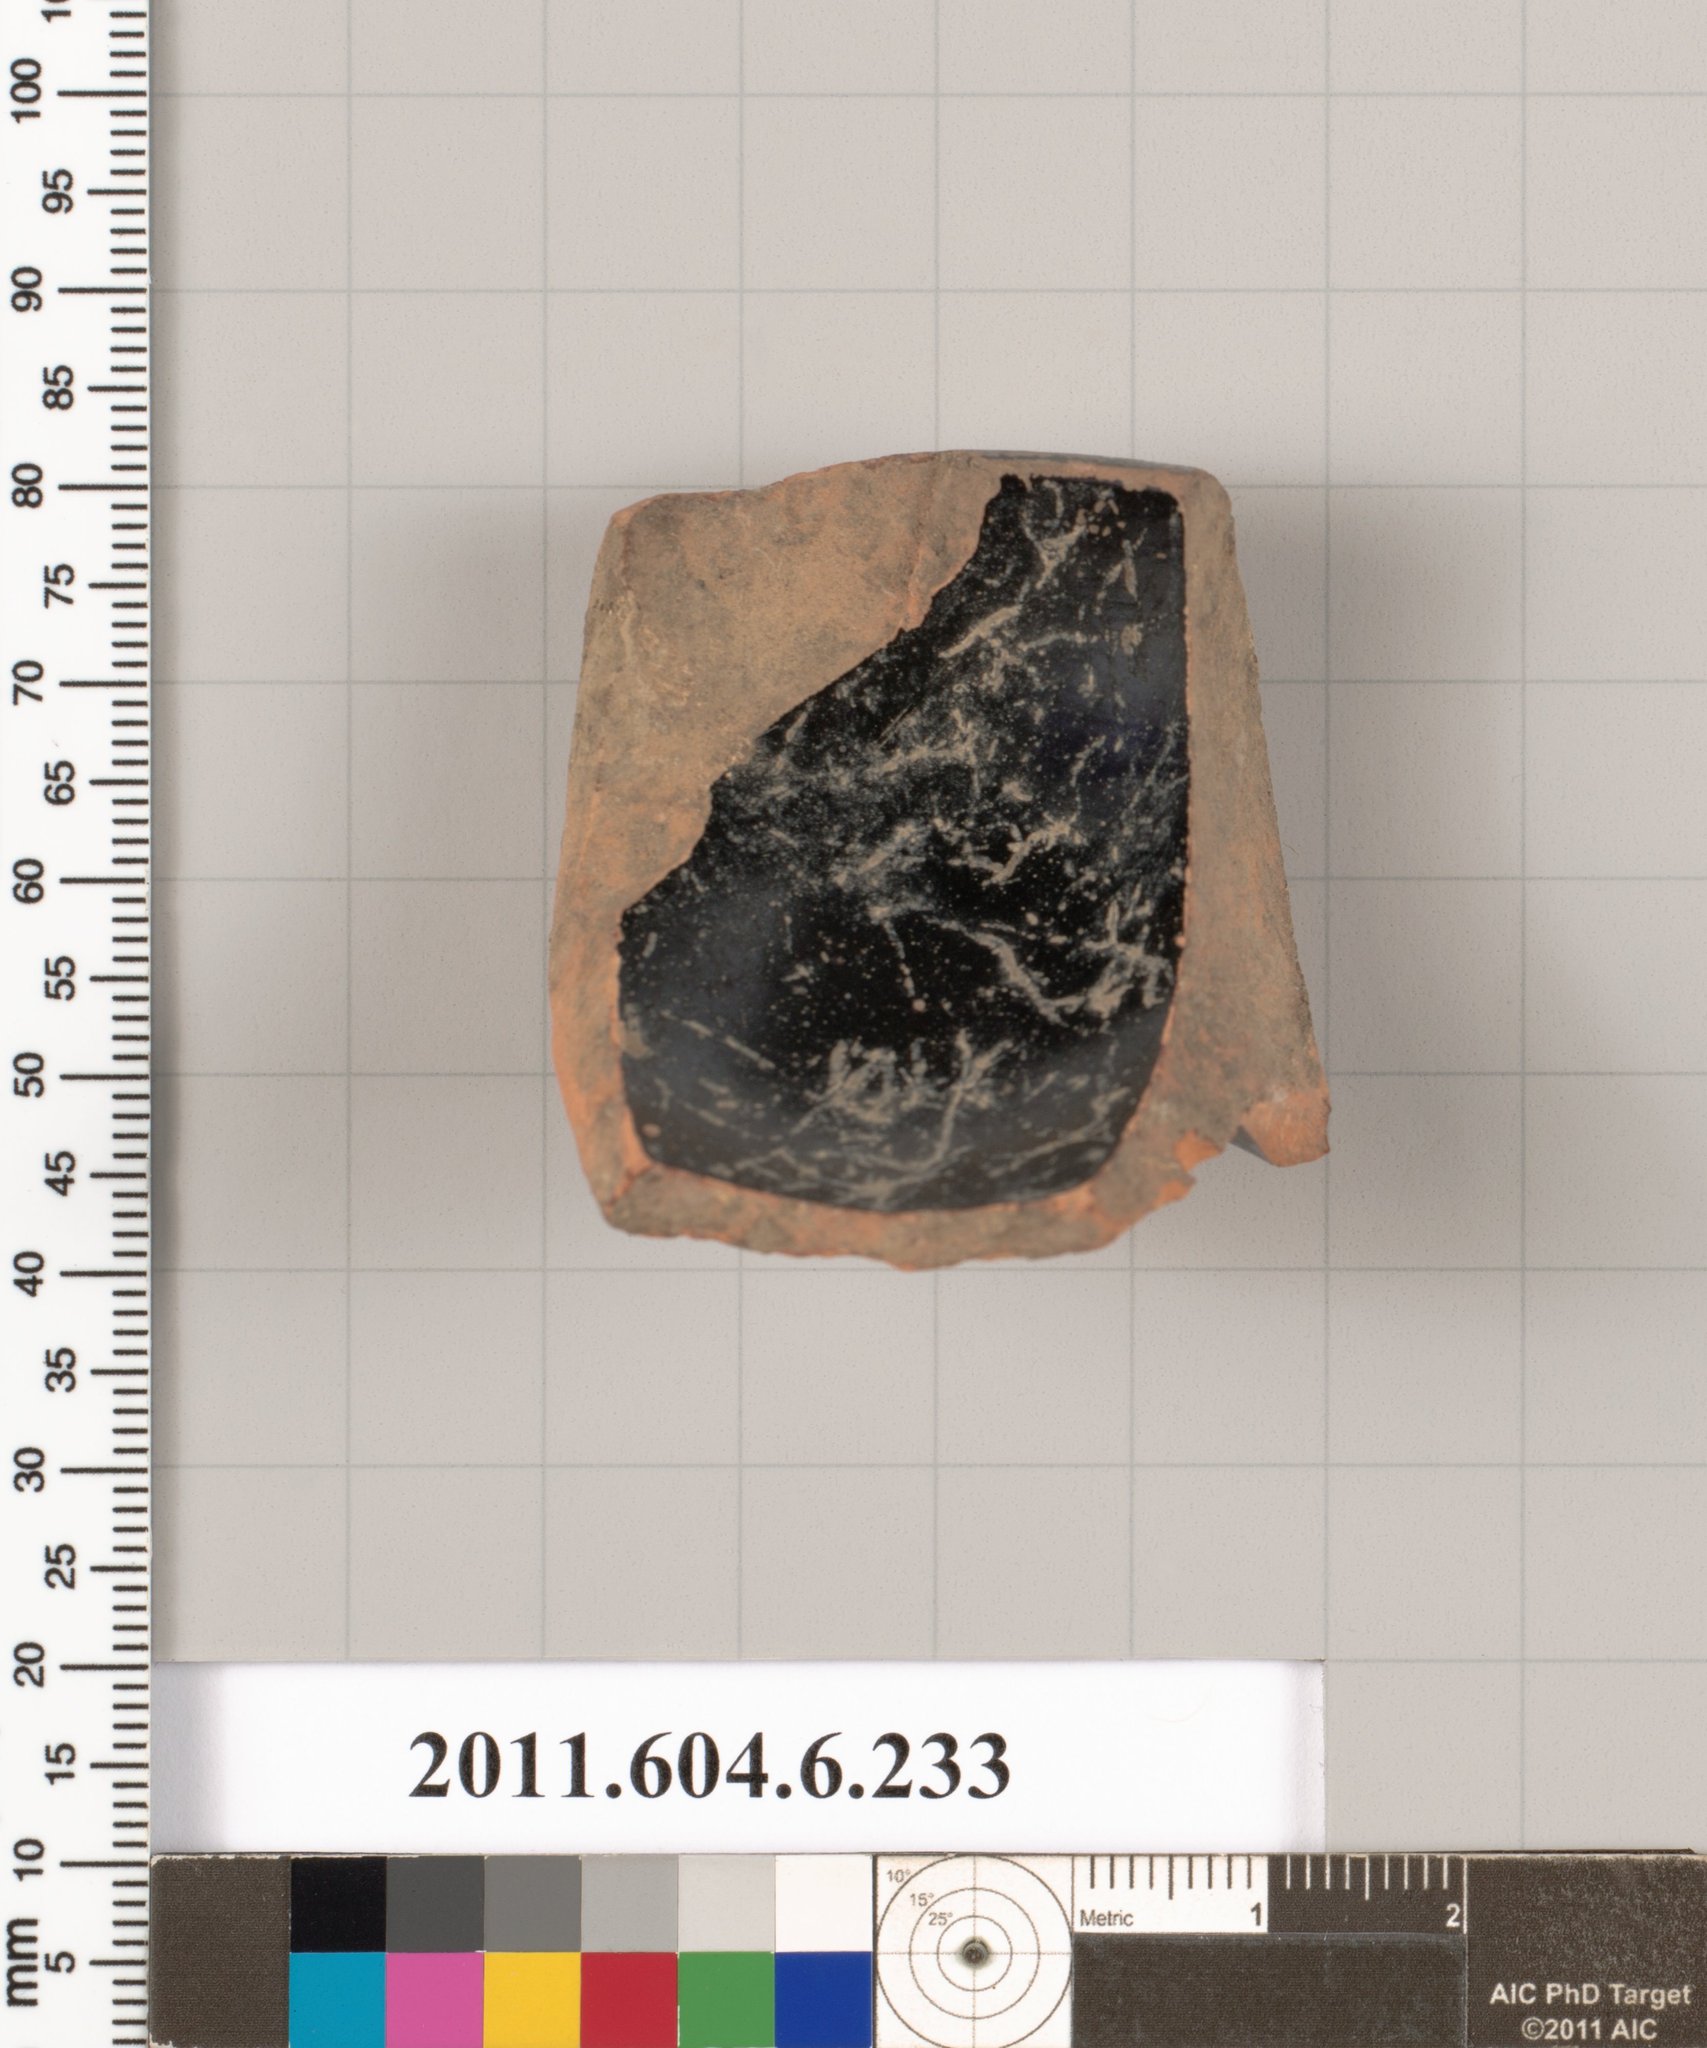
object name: salt cellar fragment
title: Terracotta fragment of a salt cellar?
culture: greek, attic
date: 500-451 BCE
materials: terracotta